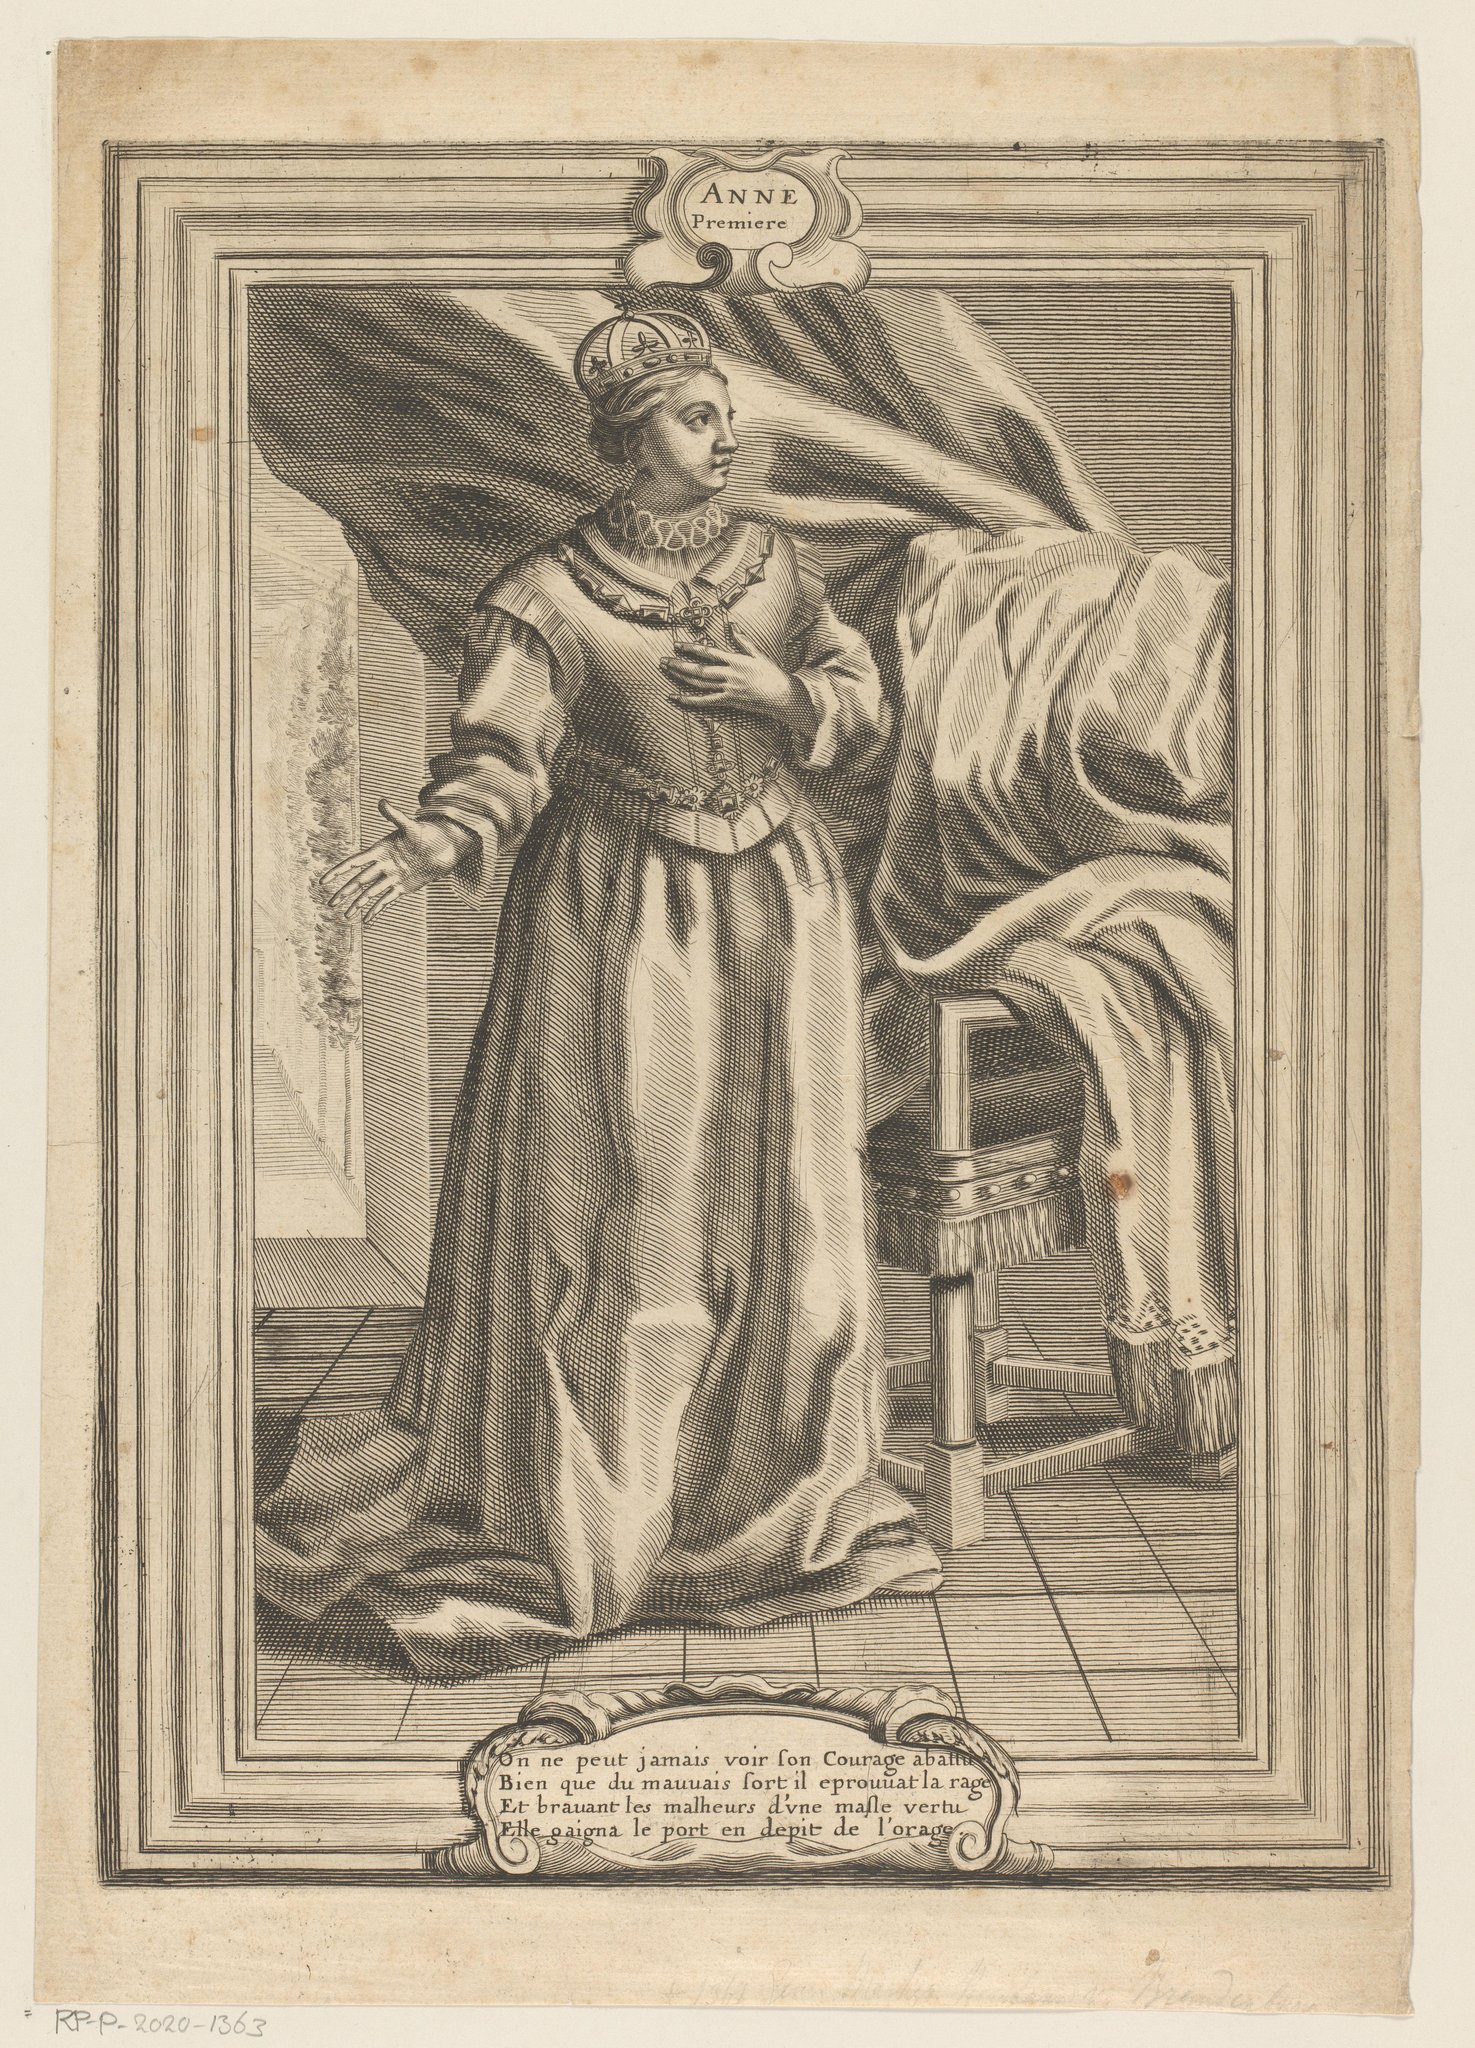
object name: print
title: Portret van Anna van Habsburg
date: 1648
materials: paper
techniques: engraving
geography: paris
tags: historical persons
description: Prent waarschijnlijk uit: Serre, Jean Puget de la. L'isthoire et les portraits des impératrices, des reynes, et des illustres princesses de l'auguste maison d'Austriche, qui ont porté le nom d'Anne. Parijs: Pierre de Bresche, 1648.